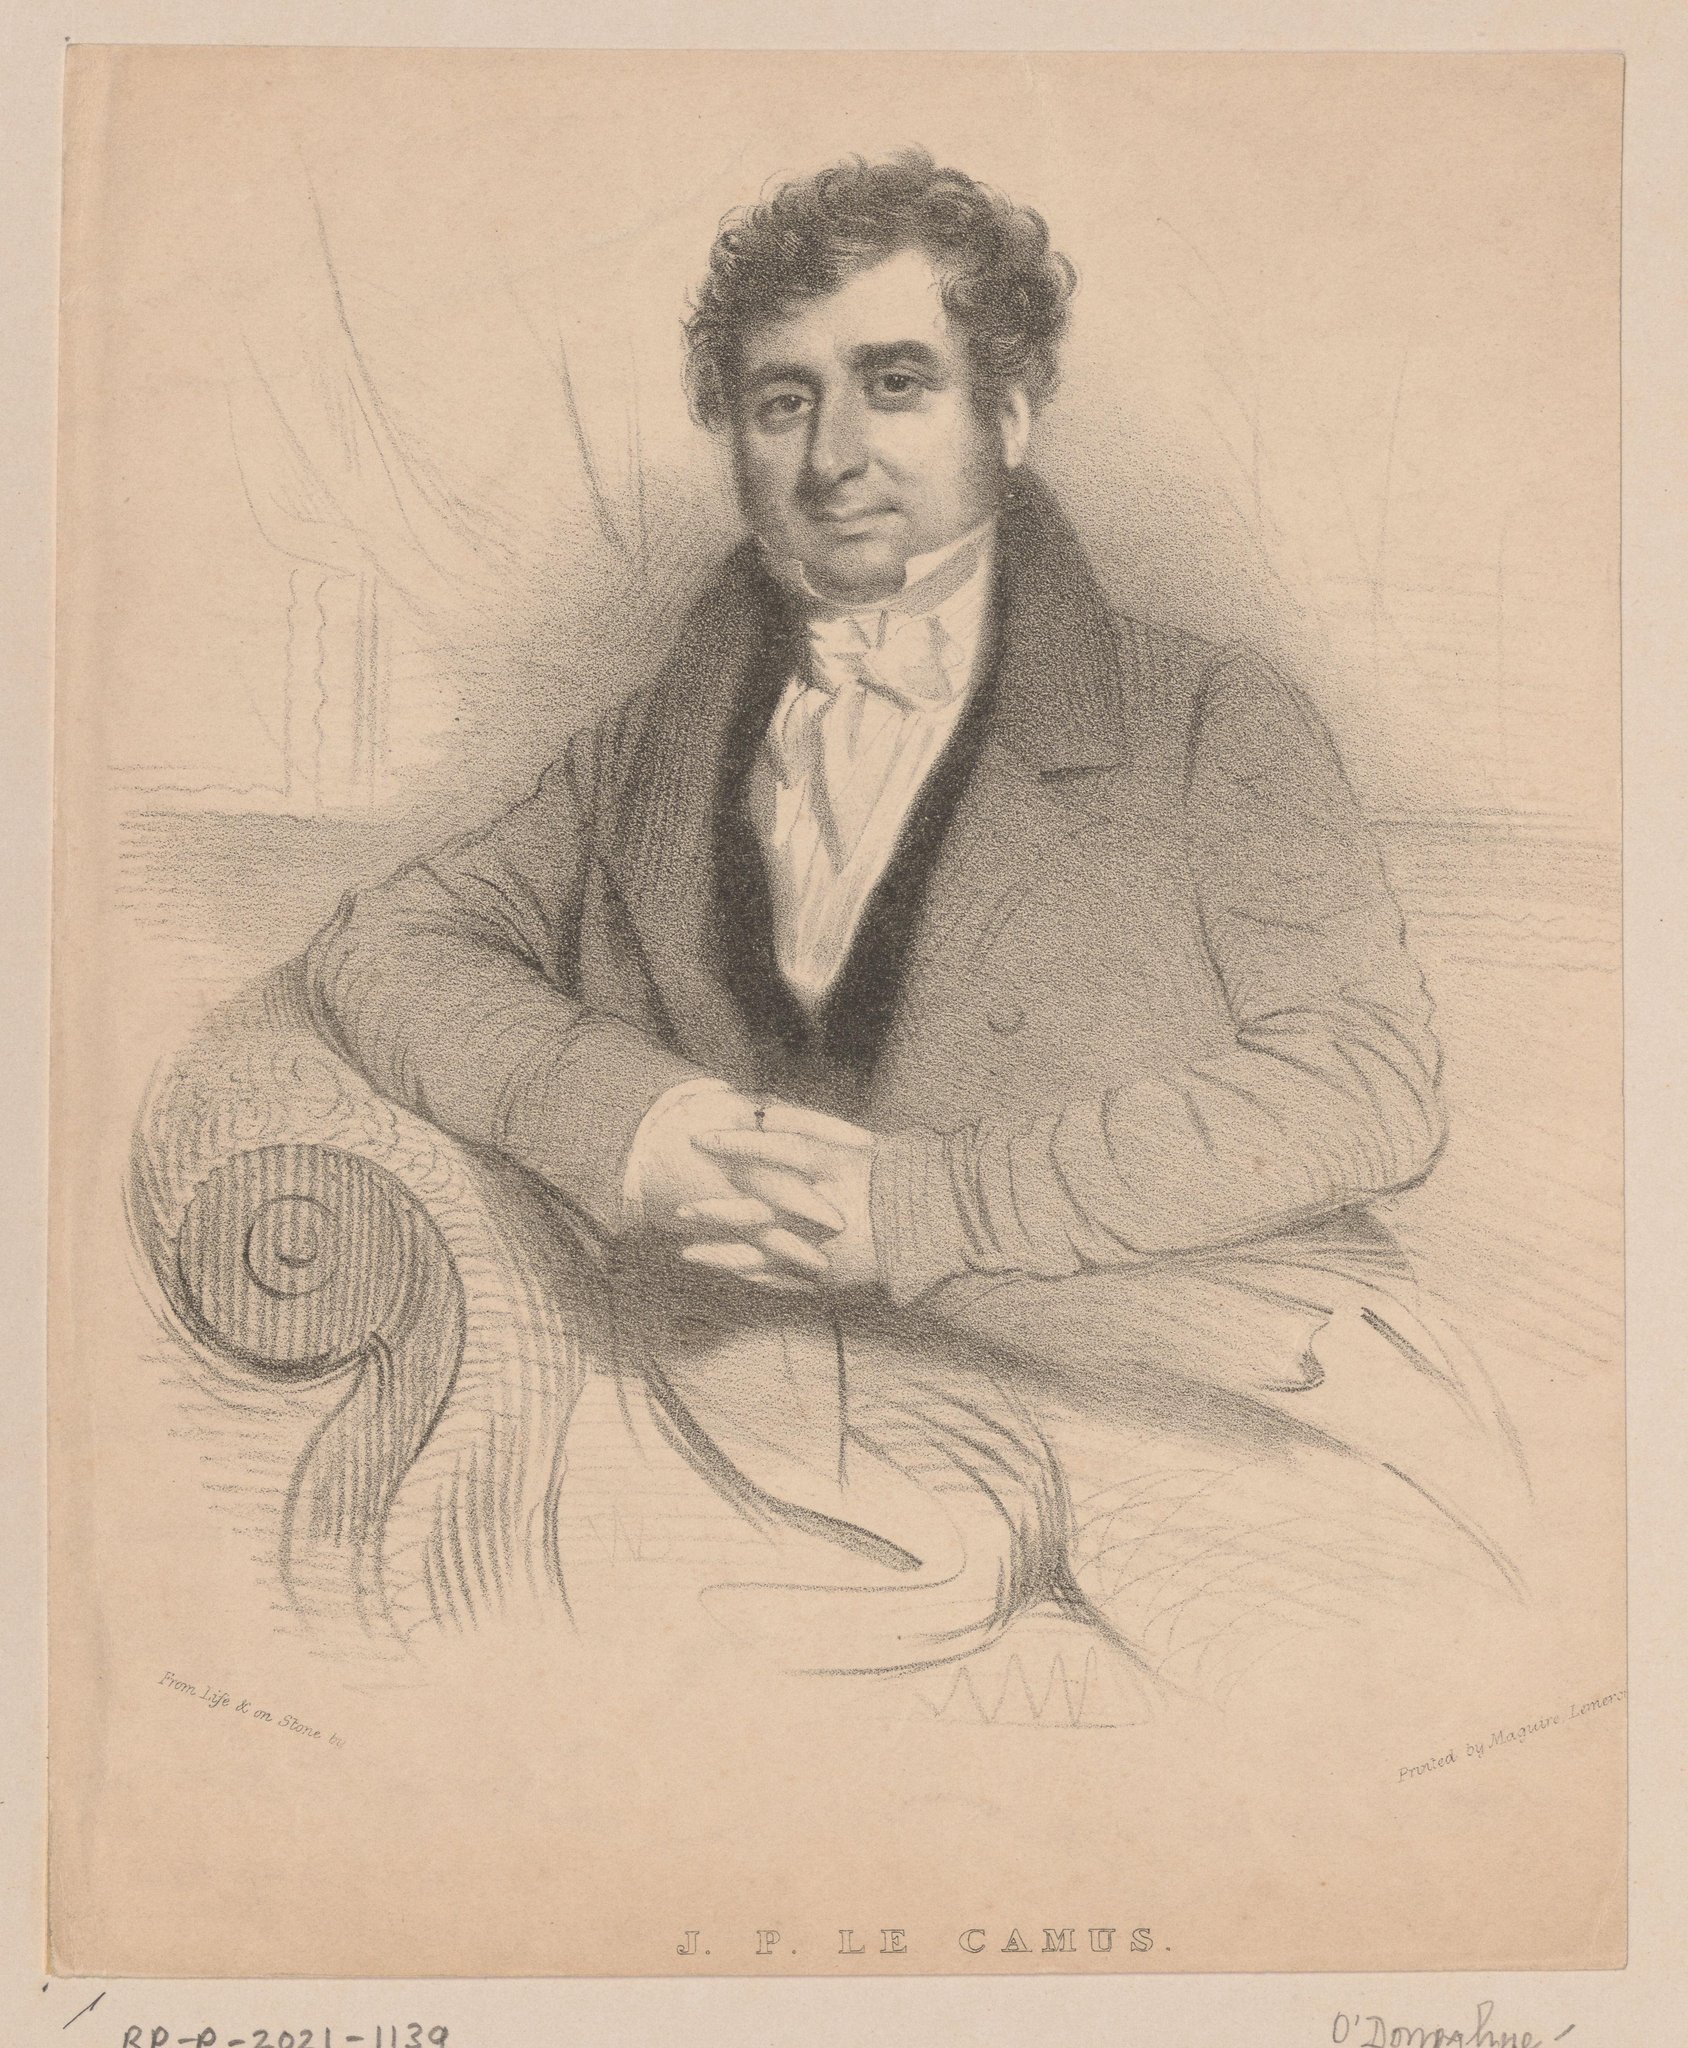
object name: print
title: Portret van J.P. Le Camus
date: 1831-1895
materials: paper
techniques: lithograph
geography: england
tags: historical persons